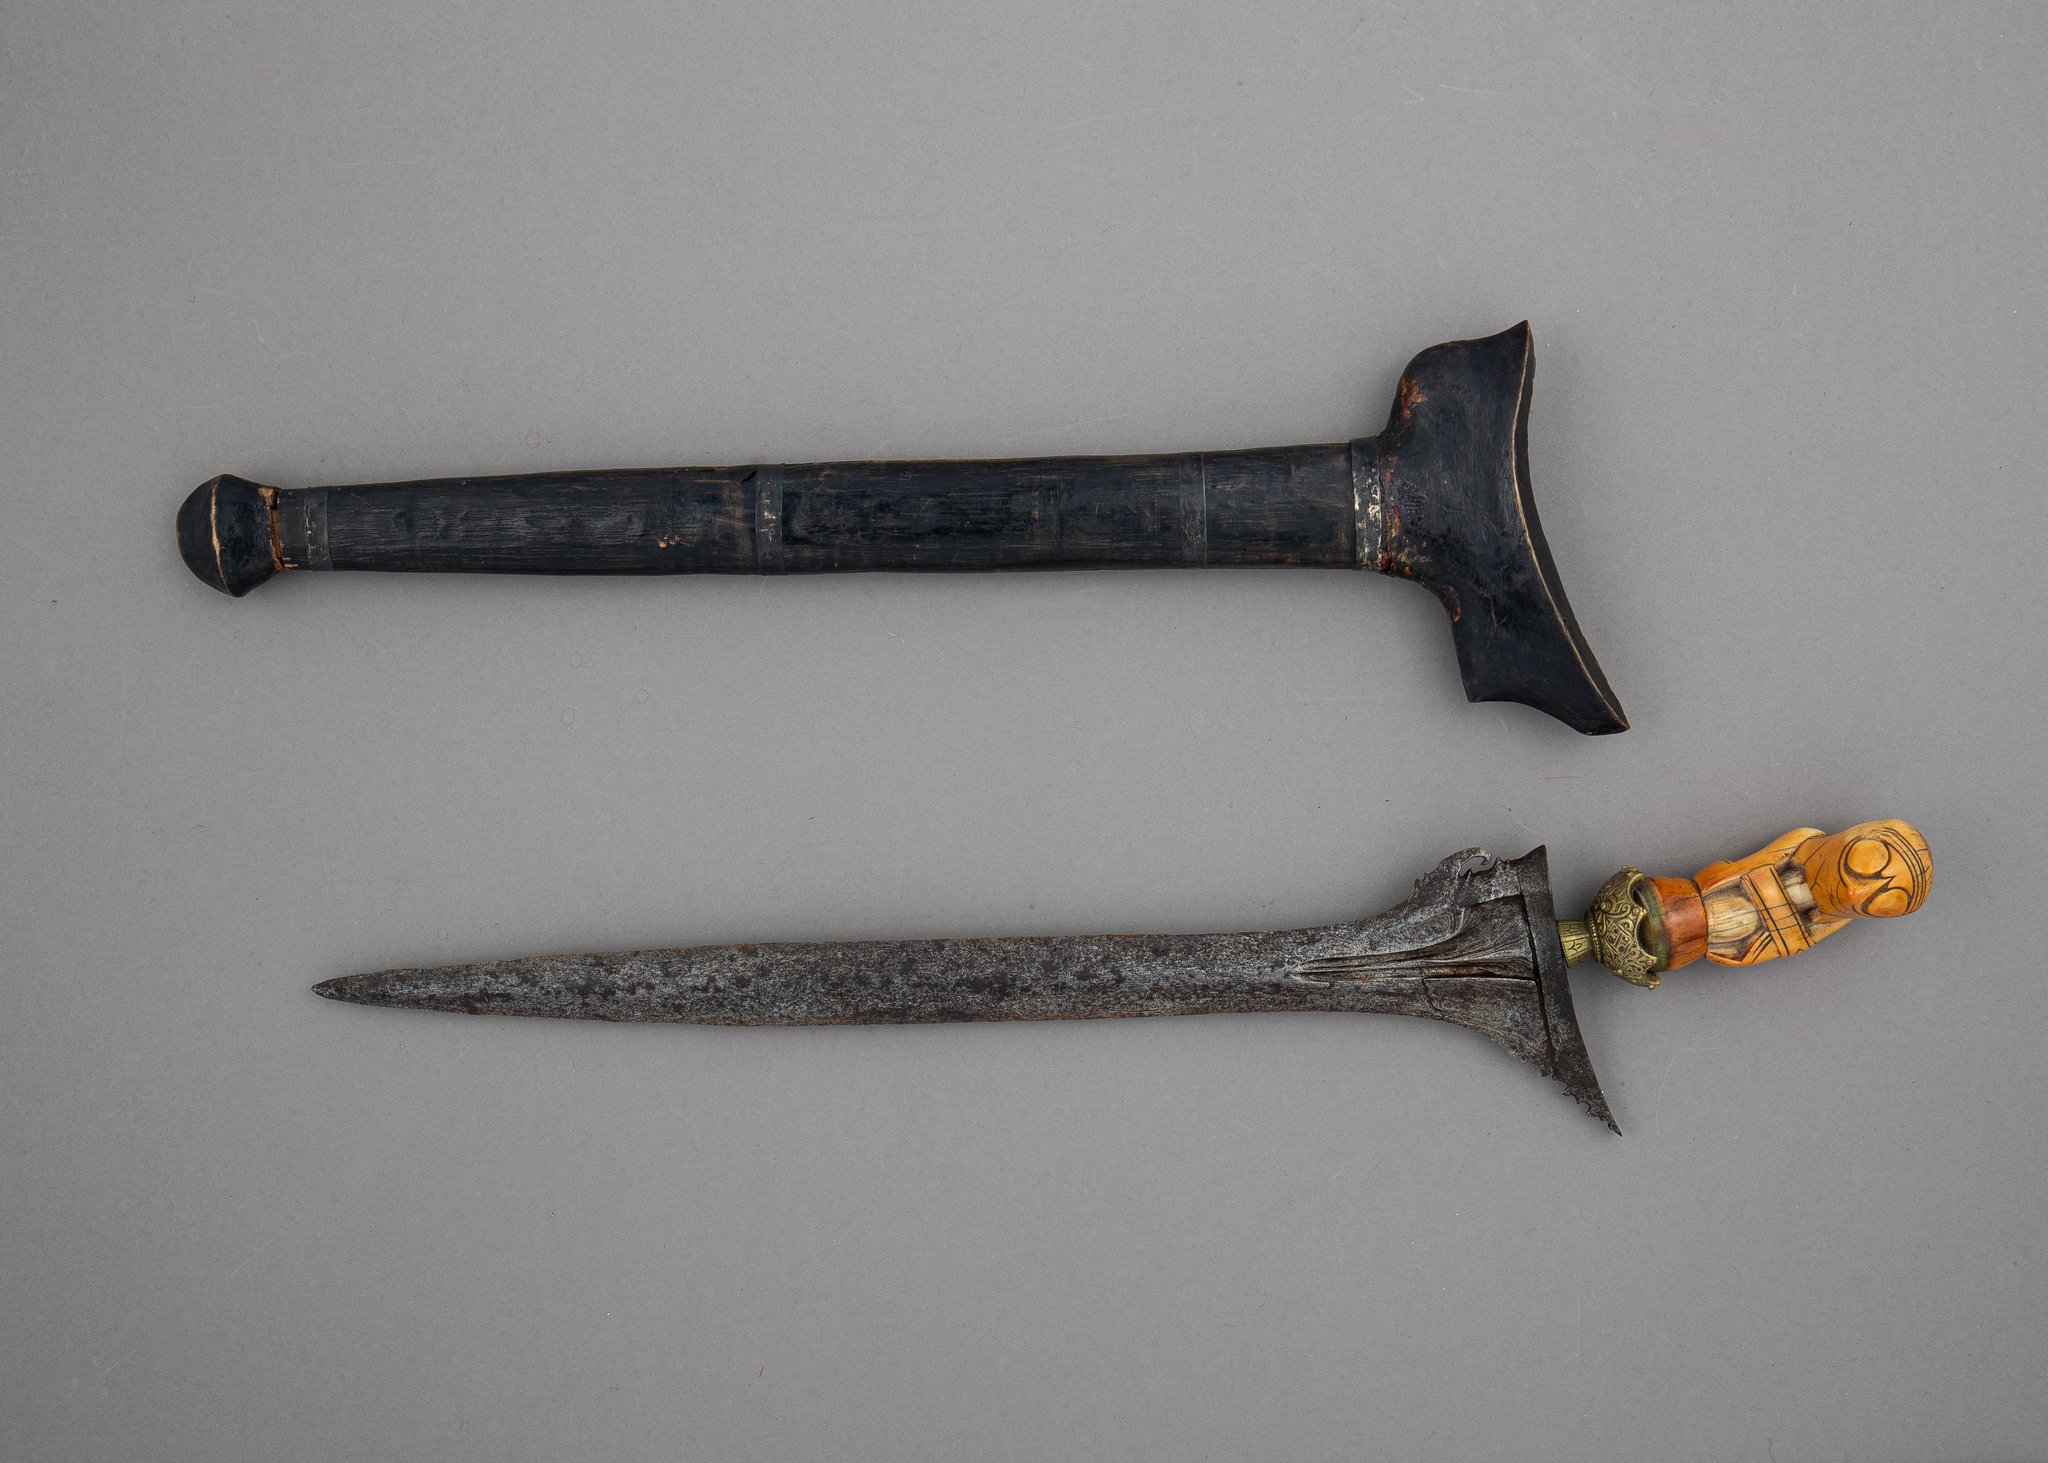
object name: kris with sheath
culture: minangkabau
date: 1501-1900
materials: brass, ivory, silver, steel, wood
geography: malaysia